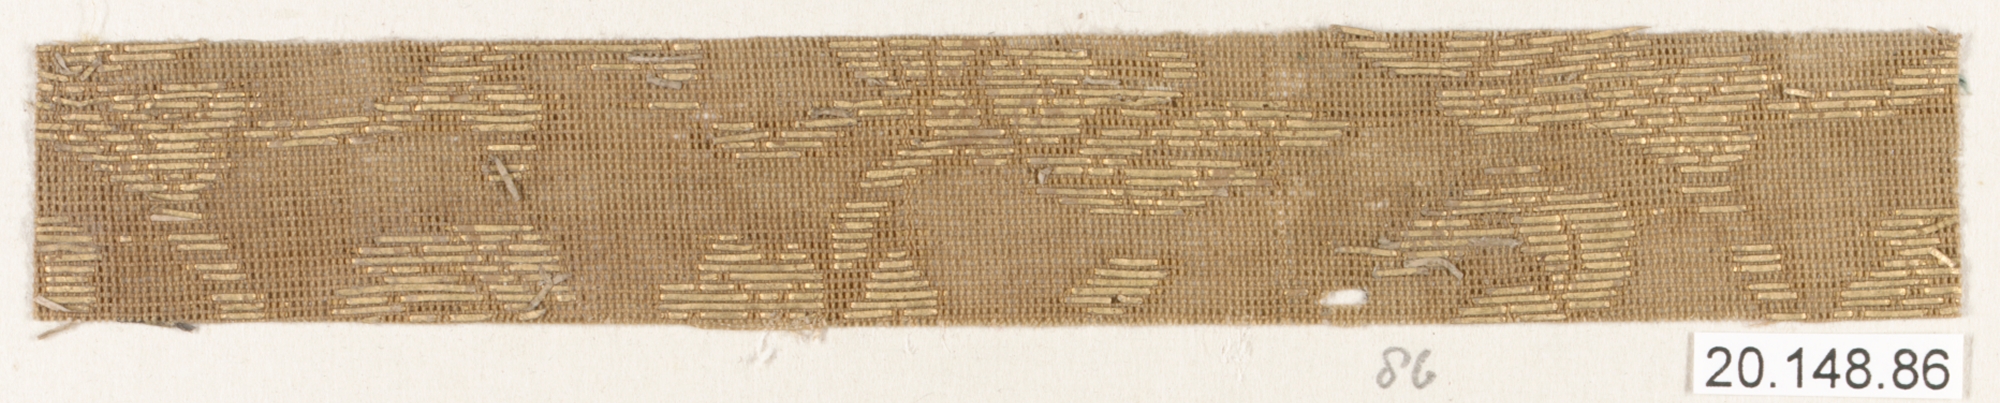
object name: piece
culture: japanese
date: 1501-1600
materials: silk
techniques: compound weave